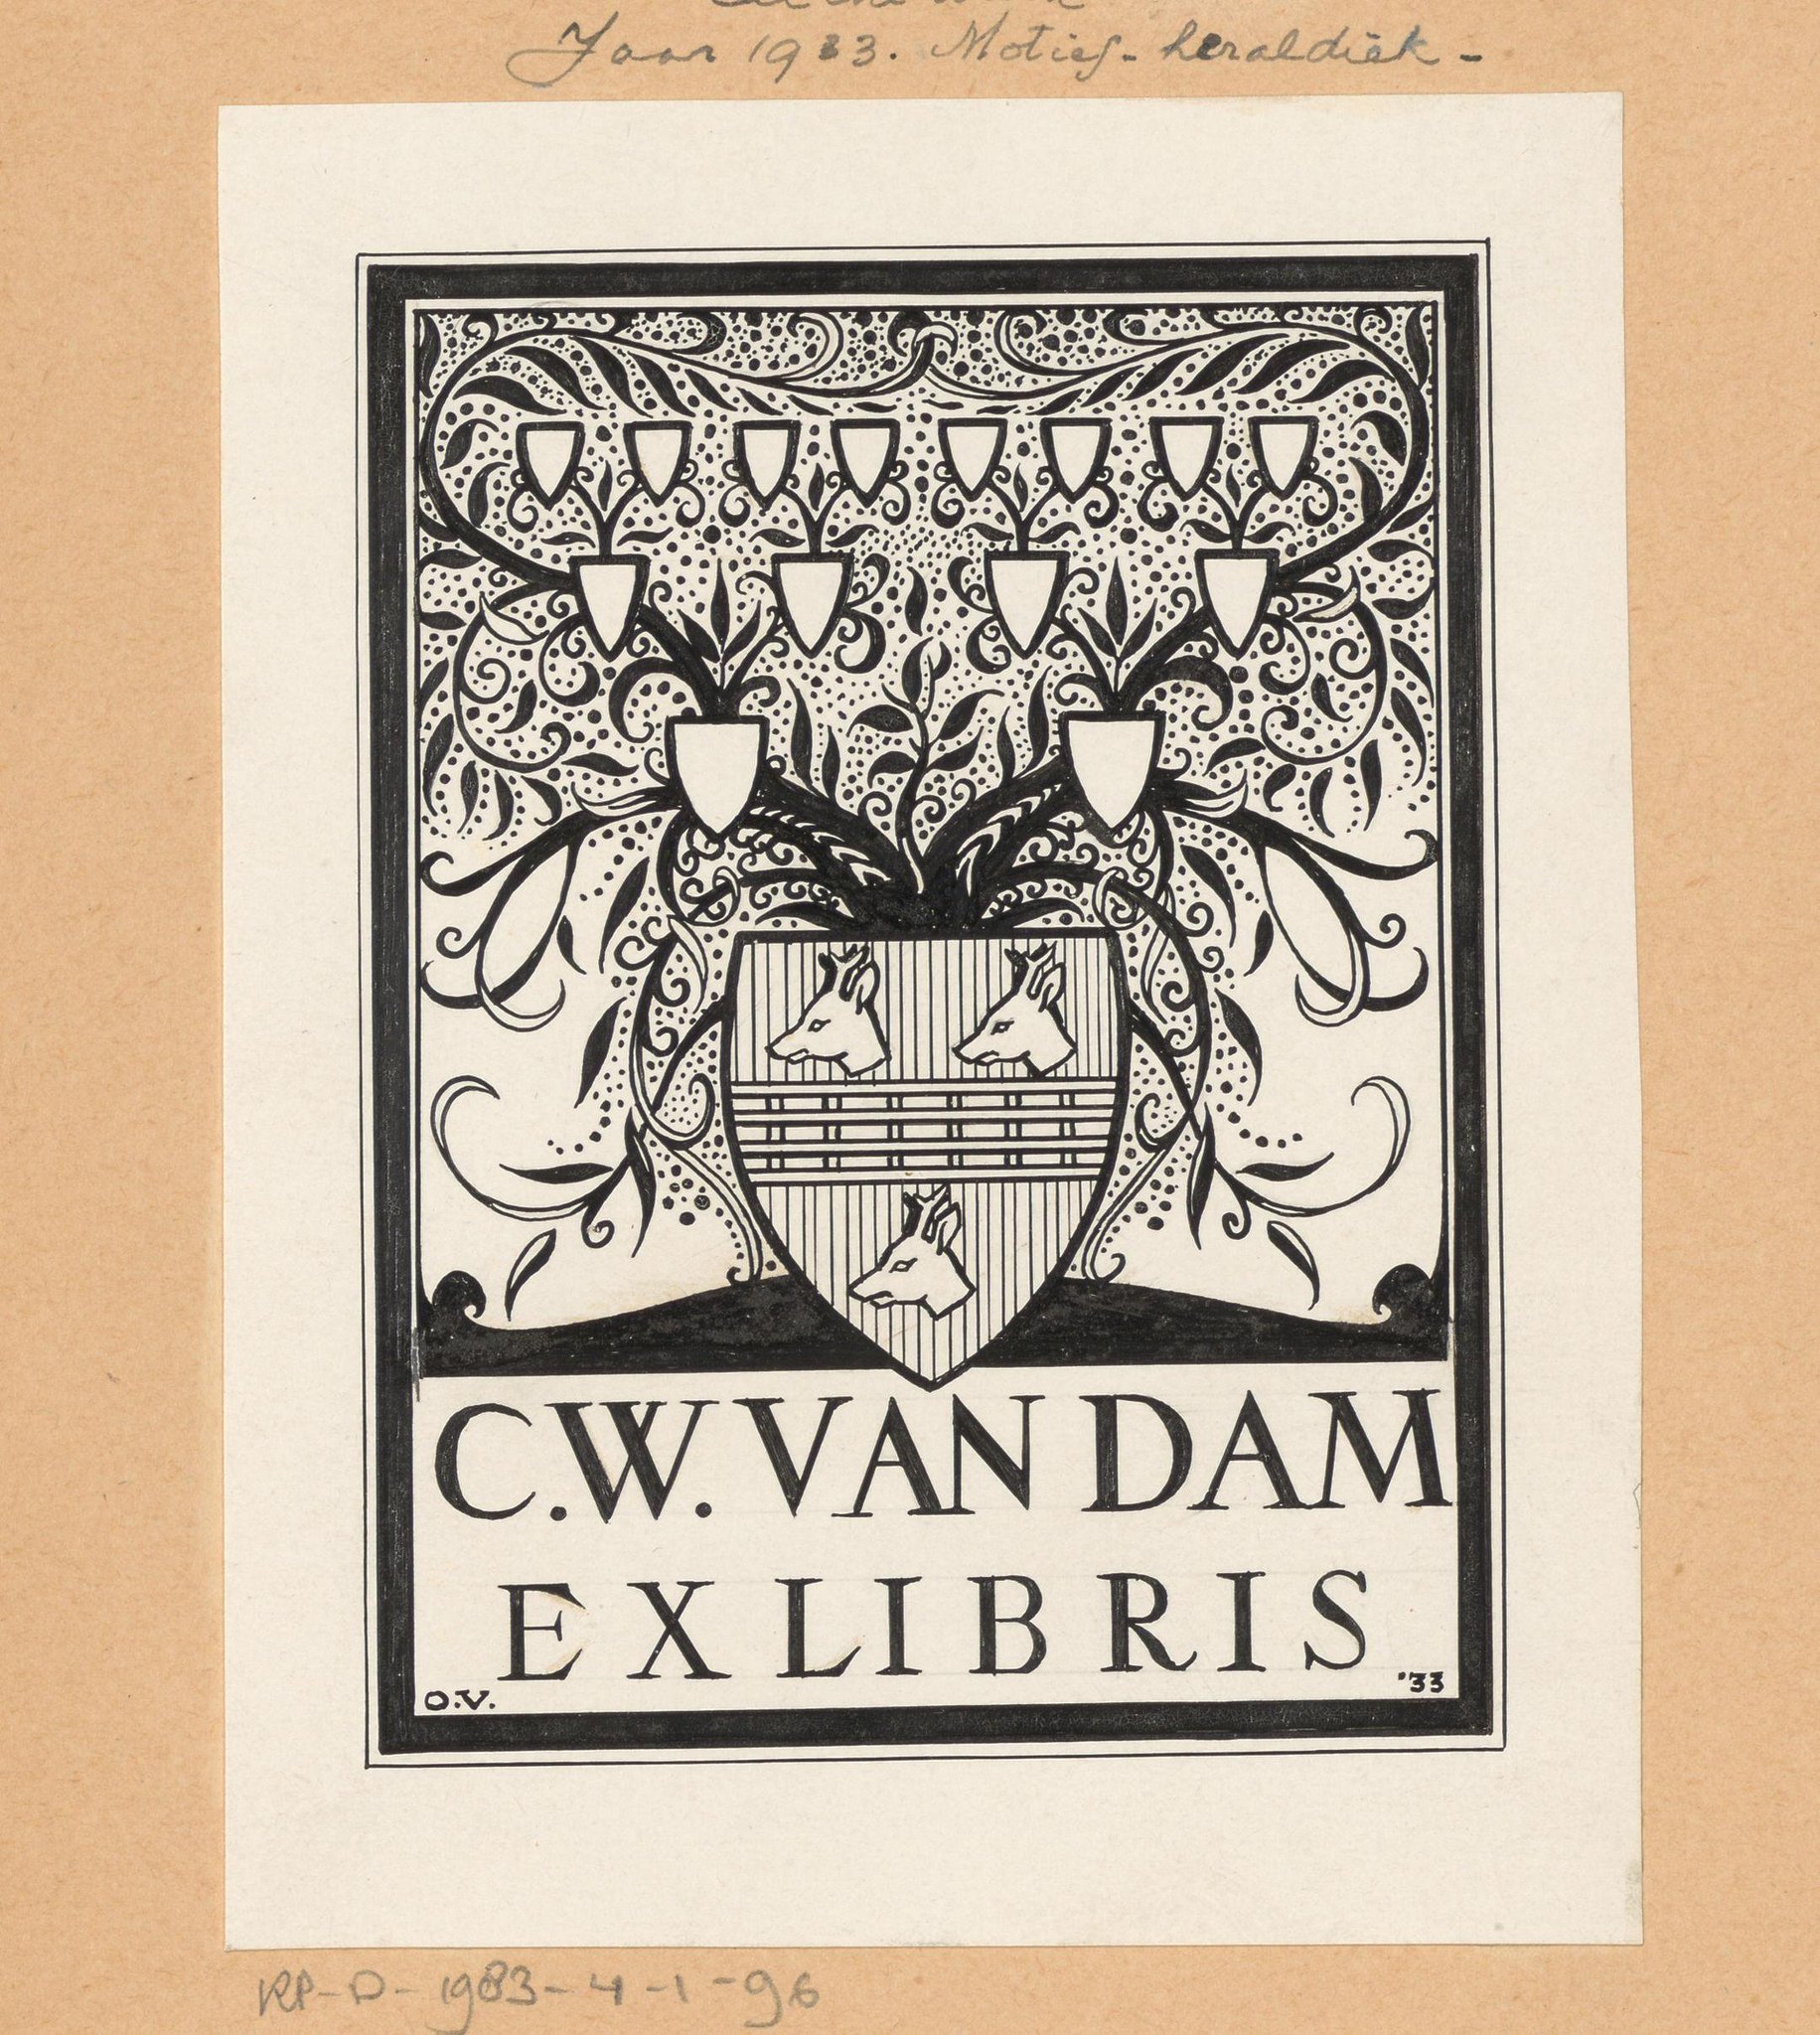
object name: design drawing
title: Ontwerptekening voof ex libris van C.W. van Dam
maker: otto verhagen (i)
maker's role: draughtsman, print maker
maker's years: 1885-1951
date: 1933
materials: ink, paper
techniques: drawing, pen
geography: netherlands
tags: trees, hoofed animals: deer, armorial bearing, heraldry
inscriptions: date